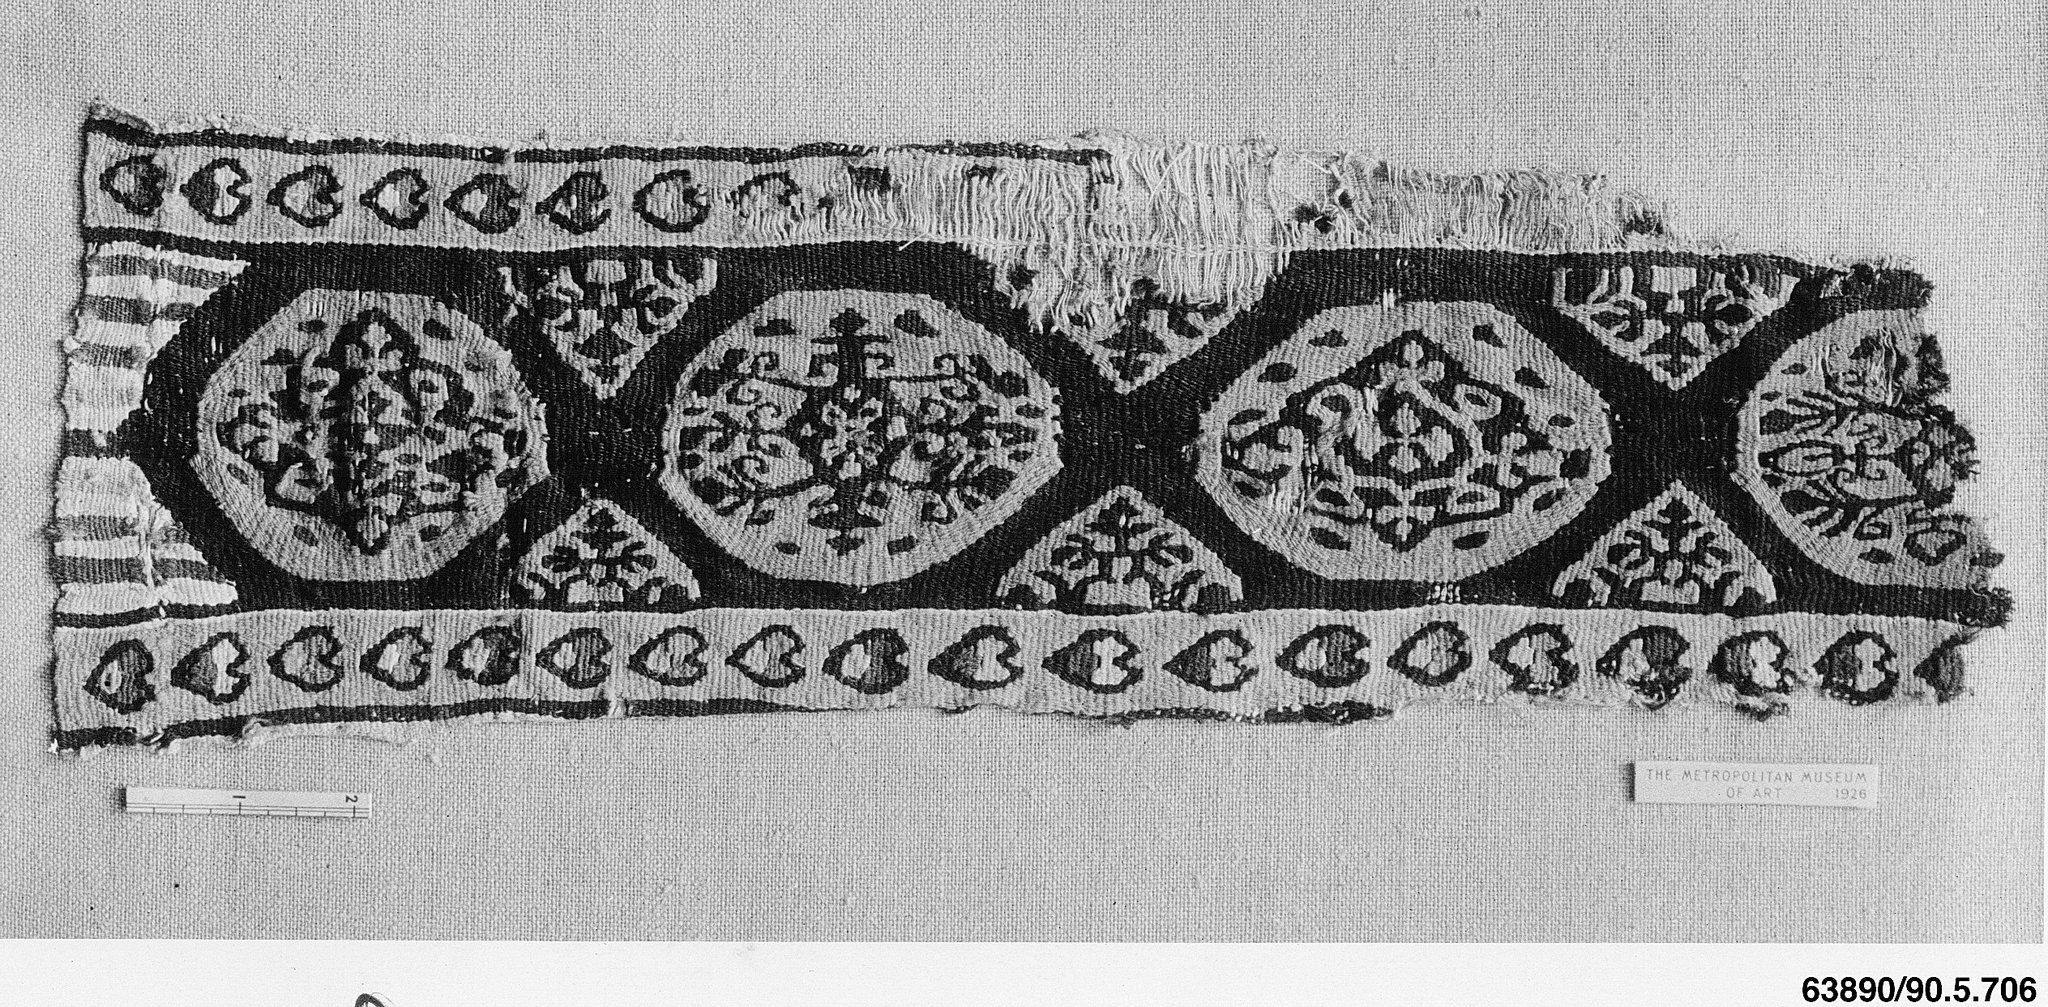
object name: textile fragment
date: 401-600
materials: linen, wool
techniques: weave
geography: egypt